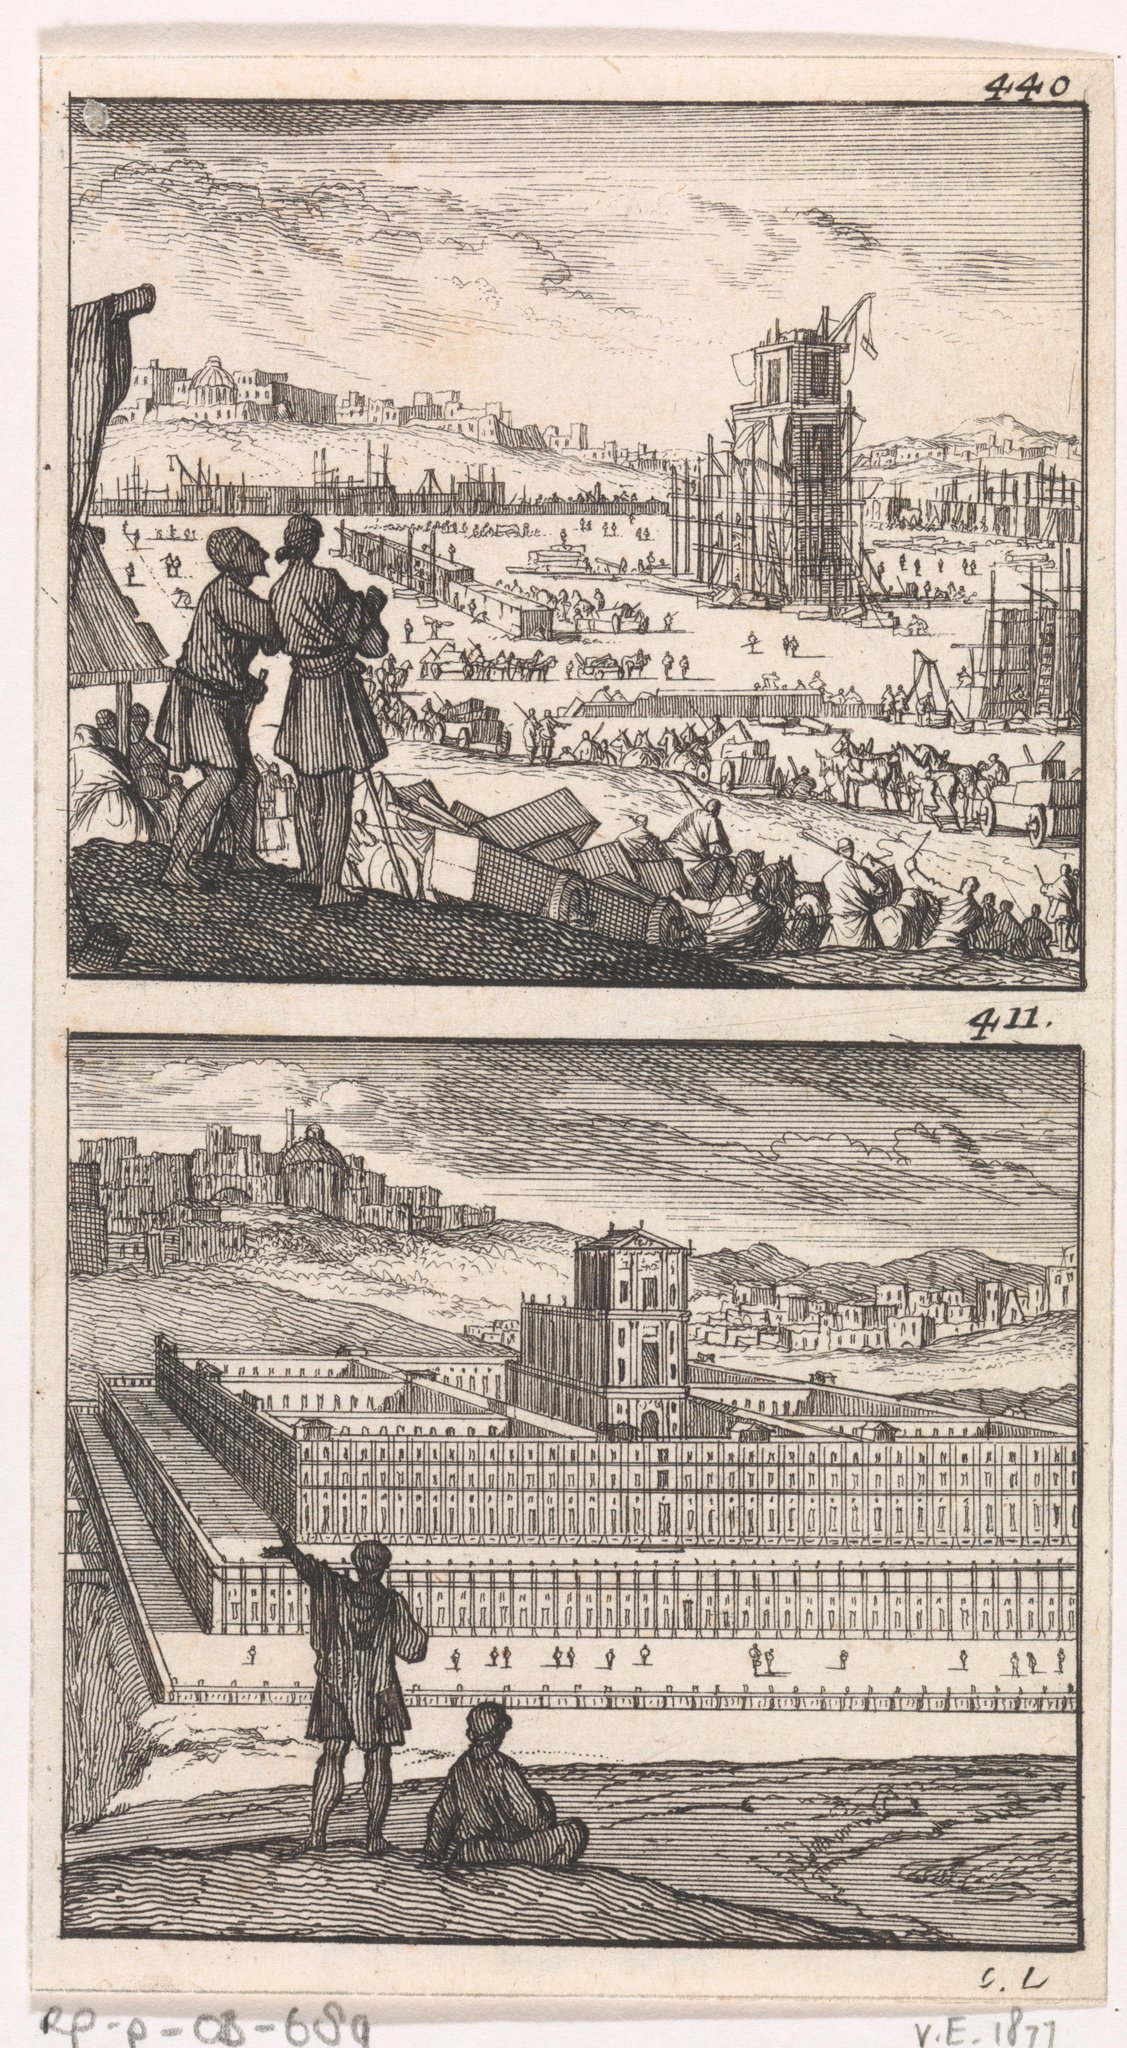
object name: book illustration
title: Salomo bouwt de tempel / Salomo's tempel voltooid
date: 1698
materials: paper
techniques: etching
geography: amsterdam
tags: the building of the temple of solomon, temple of solomon (1 kings 5-9; 2 chronicles 2-7)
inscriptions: collector's mark: Lugt 2228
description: Illustratie uit: Josephus, Flavius. XX. boeken van de oude geschiedenissen der joden, 4 delen. Amsterdam: Barent Visscher, Willem de Coup, Willem van Lamsveld, Andries van Damme, 1698, dl. I.